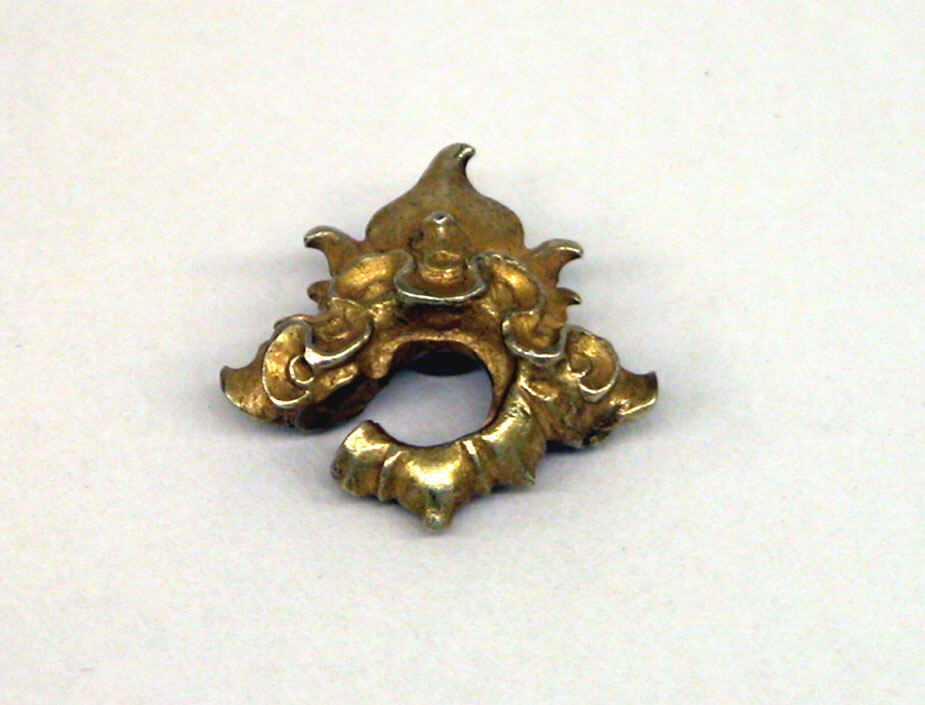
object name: ear ornament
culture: indonesian, javanese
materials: gold